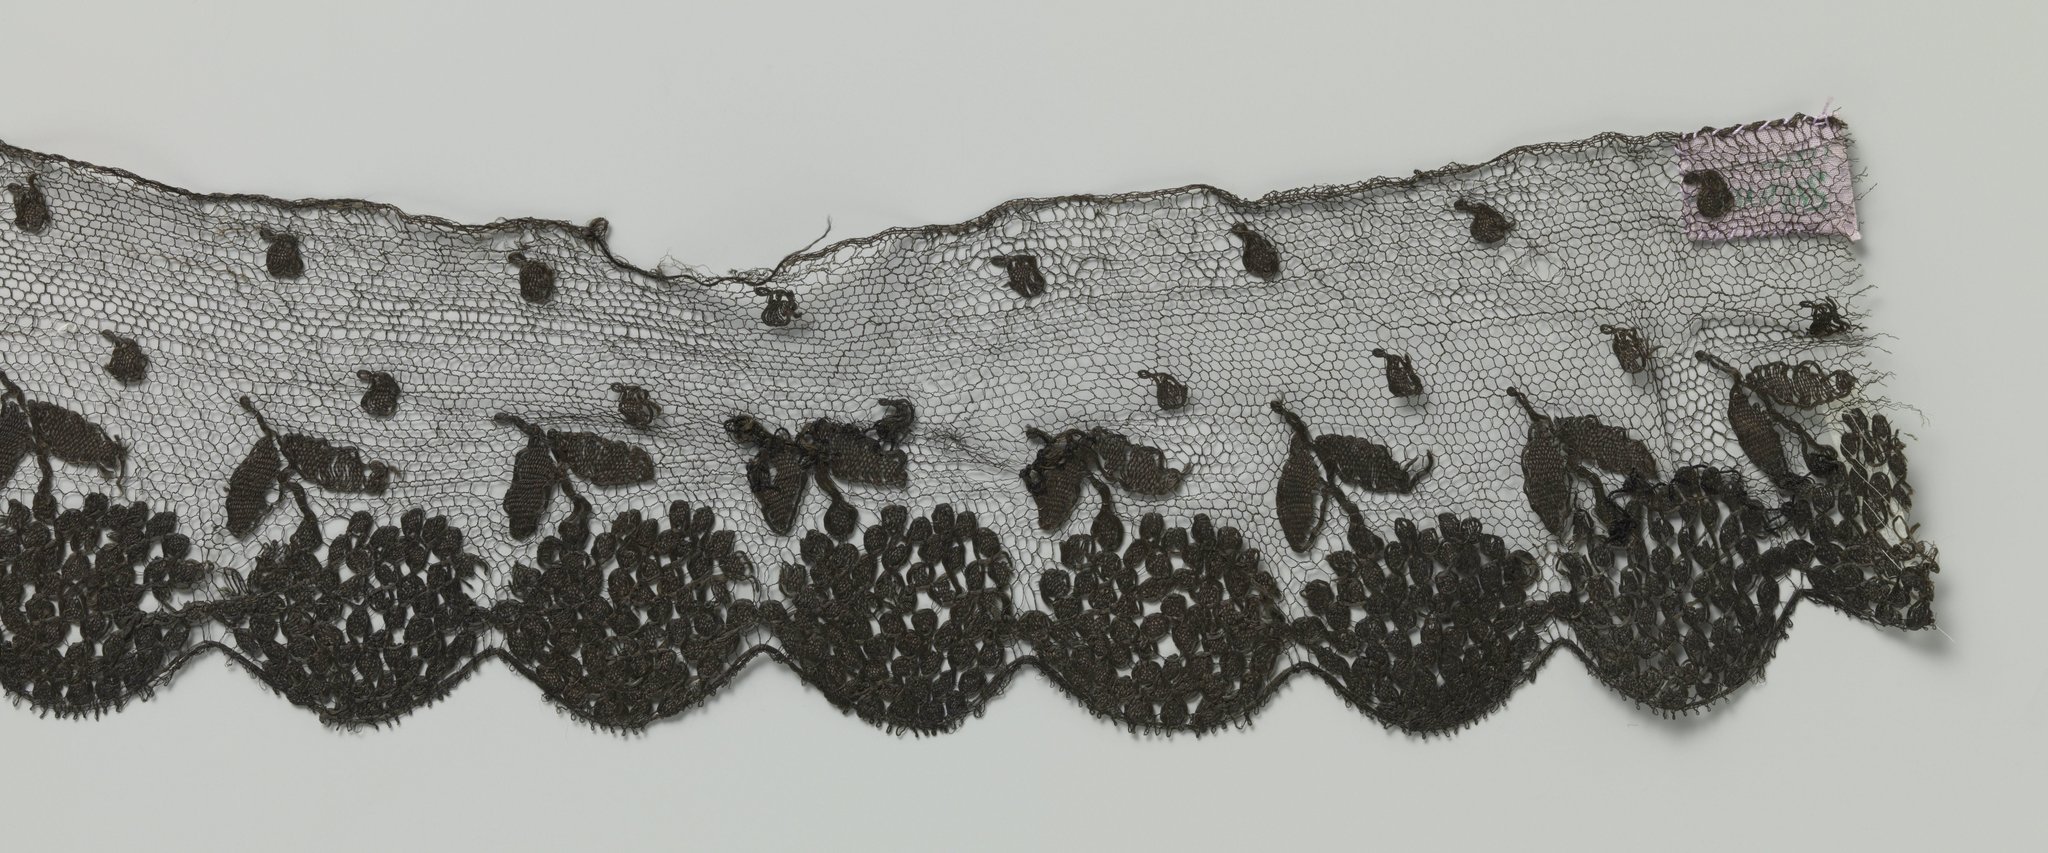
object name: strip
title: Strook kloskant met hangende ronde trosbloemen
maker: Anonymous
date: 1820-1829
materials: silk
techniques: lace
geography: southern netherlands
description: Strook zwarte kloskant, blonde. Het zich herhalende patroon bestaat langs de onderzijde van de strook uit aaneengeschakelde ronde trosbloemen, die aan kromme steeltjes met twee blaadjes naar beneden hangen en op die manier halfronde schulpen vormen. Boven de bloemen staat een strooipatroon van twee rijen ronde motiefjes. De bloemen zijn gemaakt met een siergrond van schuingeplaatste rijen aaneengeschakelde ronde motiefjes, met elkaar verbonden door overstekende paren. De blaadjes en (aaneengeschakelde) ronde motiefjes zijn gemaakt in linnenslag en voorzien van dikkere contourdraden. De motieven zijn met elkaar verbonden door een fijne maasgrond, een tulegrond. De bovenzijde van de strook is recht afgewerkt. De schulpenrand aan de onderzijde is afgewerkt met picots.